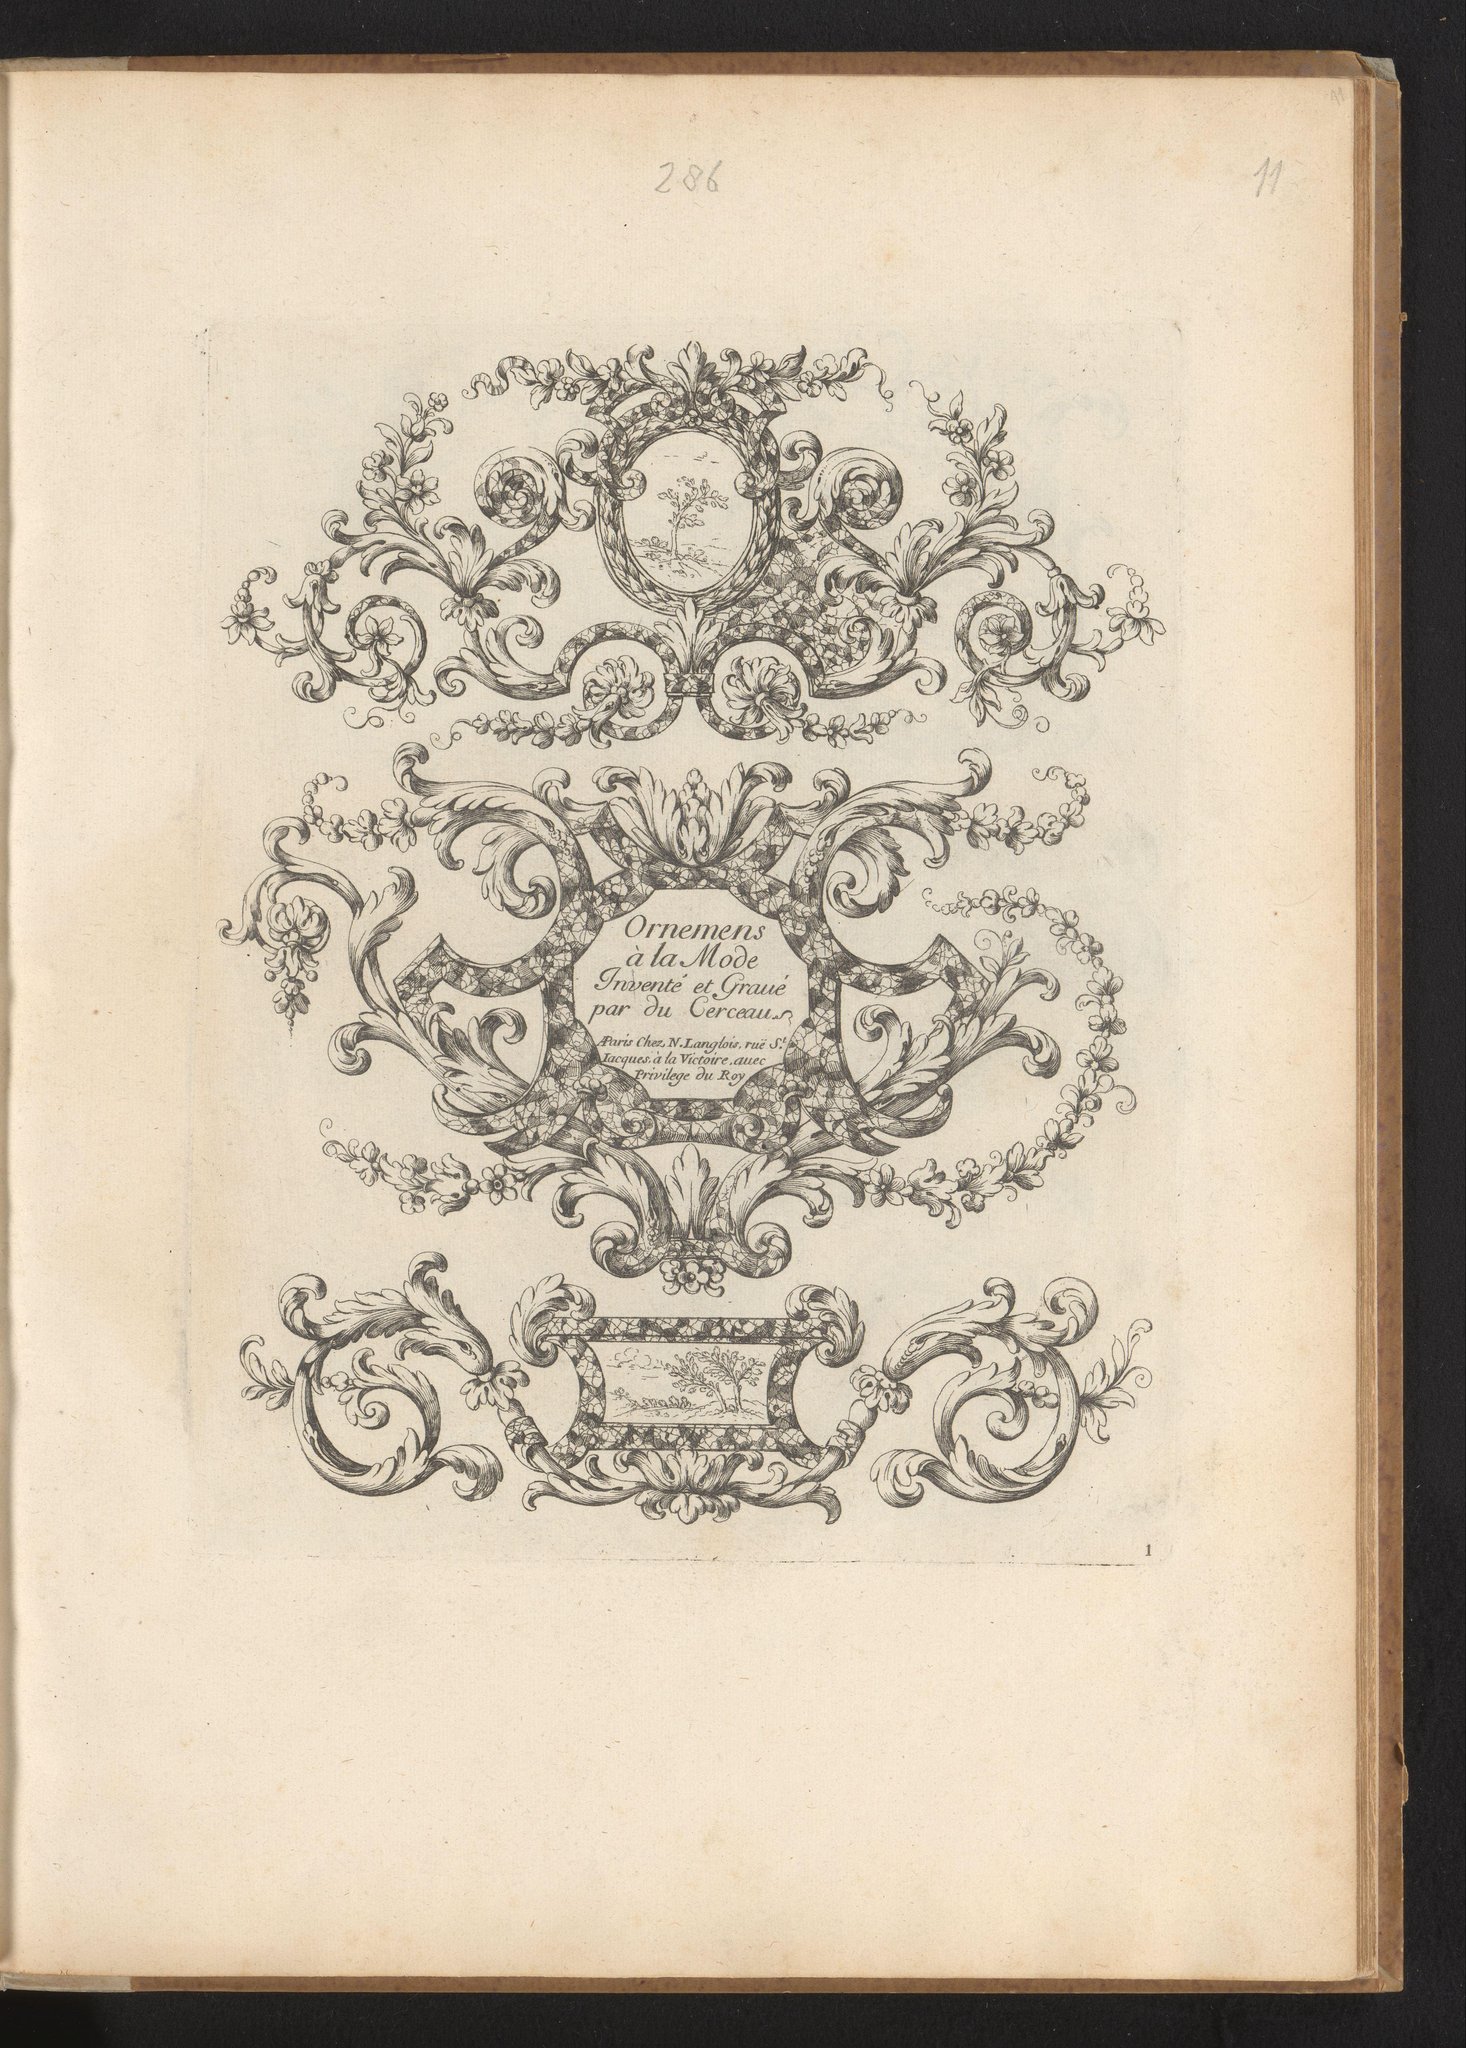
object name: titelprent, frontispice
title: Ornemens à la Mode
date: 1670-1690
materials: paper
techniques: etching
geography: paris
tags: trees, landscapes, acanthus ~ ornament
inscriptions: collector's mark: Lugt 2228a, collector's mark: Lugt 2760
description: Drie ornamenten met medaillons met van boven naar beneden daarin een boom, de titel en een landschap. Deze prent maakt deel uit van een album.